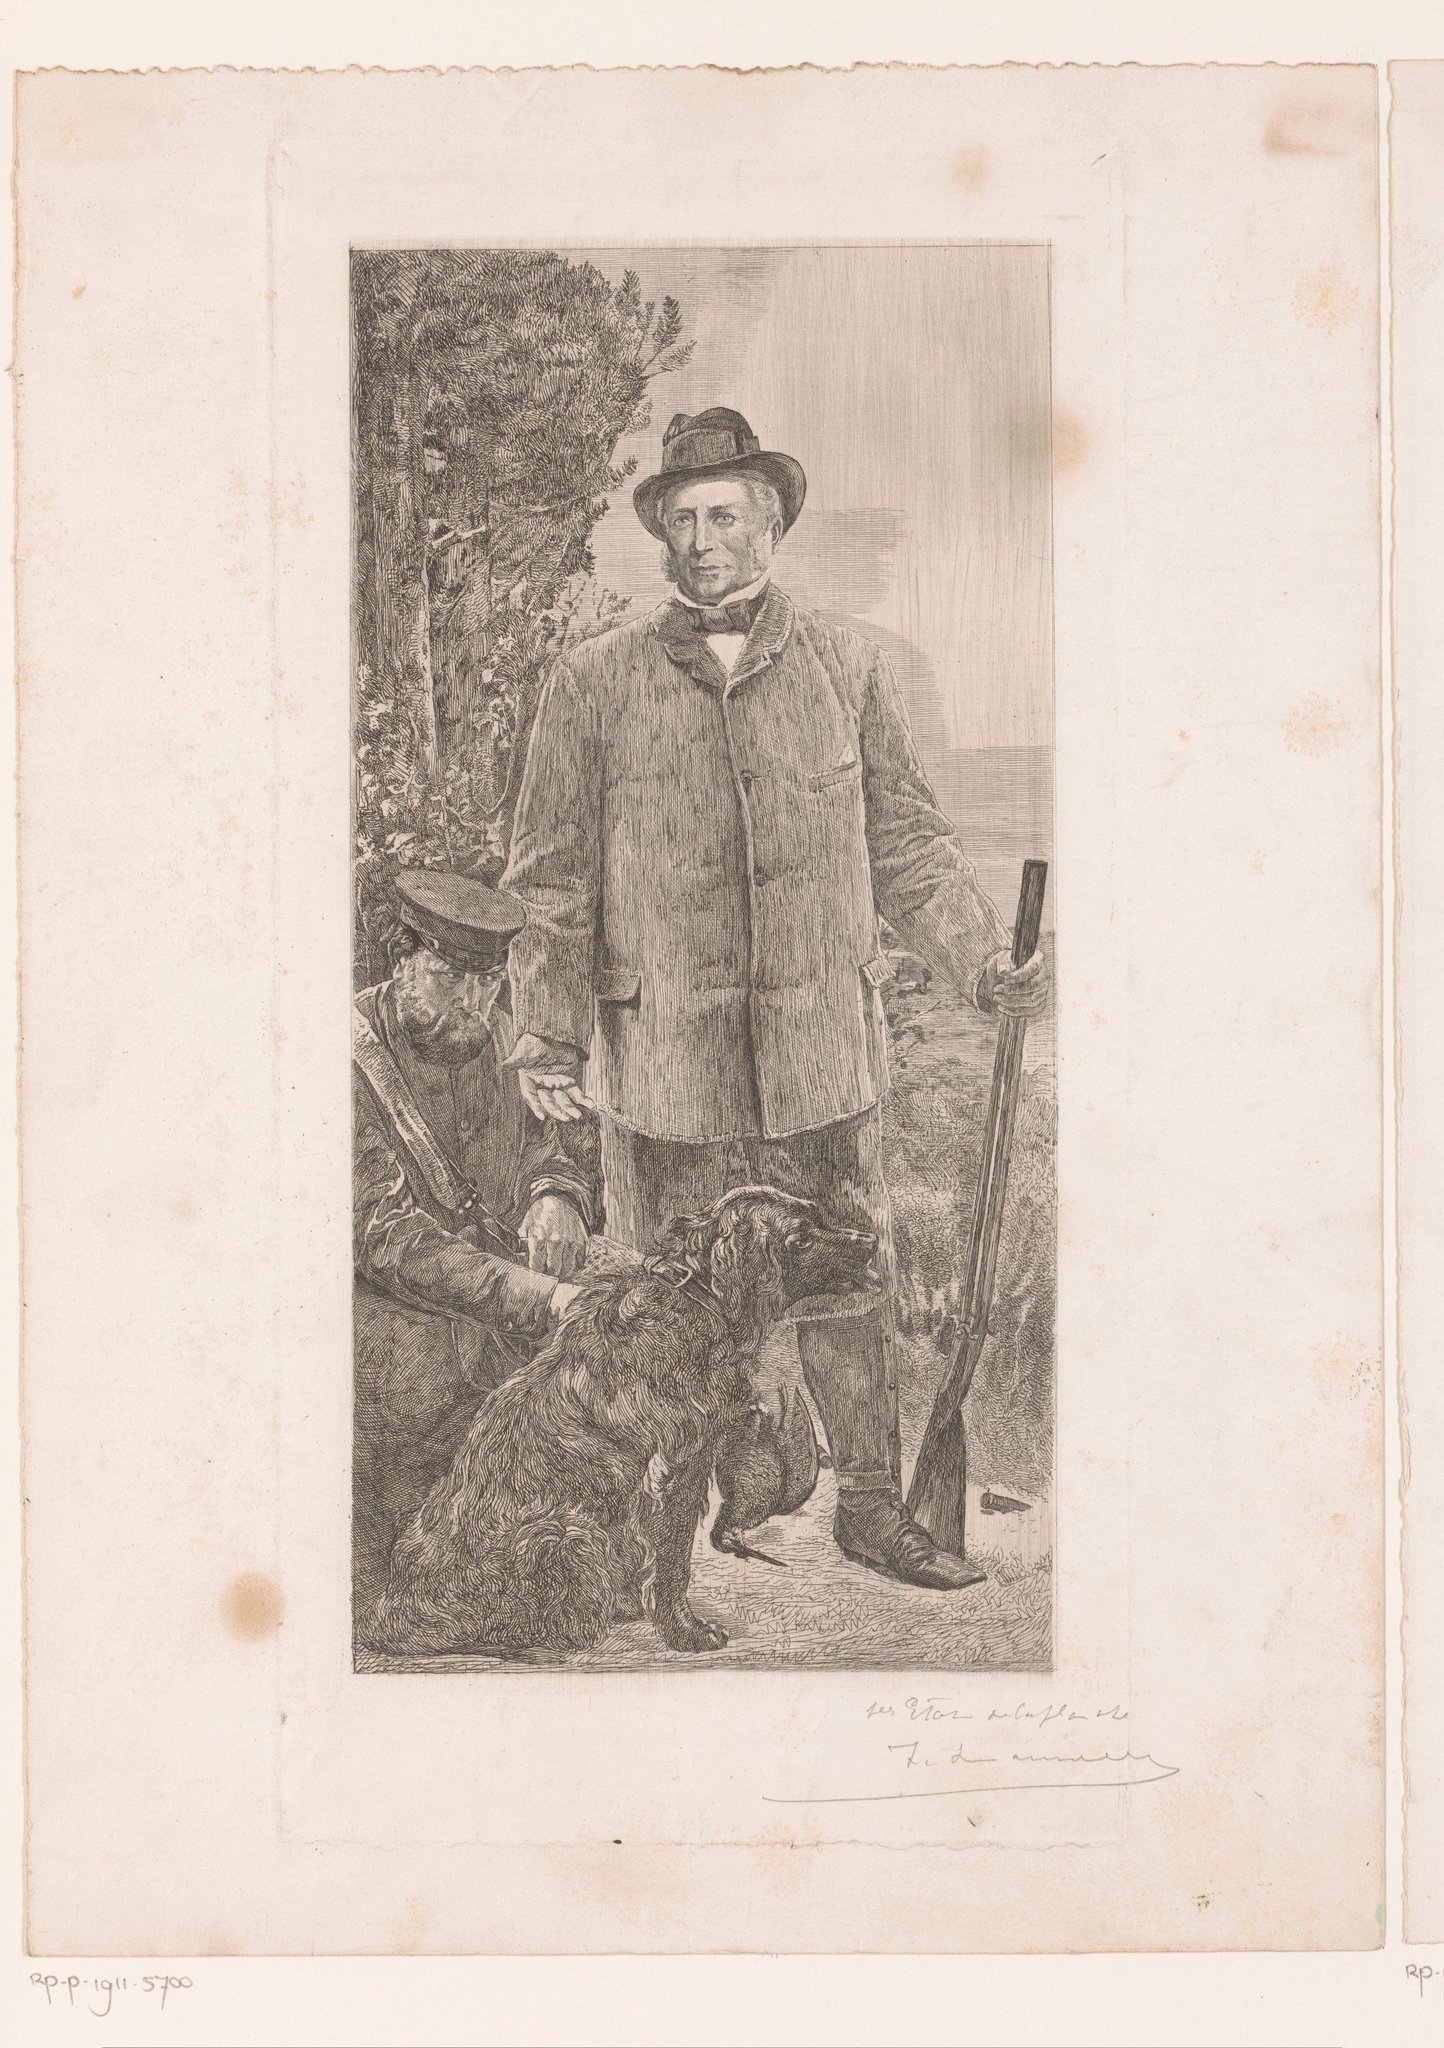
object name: print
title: Onbekende man met jachtgeweer, mogelijk Max van den Berge, aan zijn zijde een knielende tweede man en jachthond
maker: frans lauwers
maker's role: print maker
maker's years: 1854-1931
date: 1864-1911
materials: paper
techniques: etching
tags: hunter, historical persons, hunting dogs beside the spoils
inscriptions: collector's mark: Lugt 2228, annotation: ‘1er État de la planche’